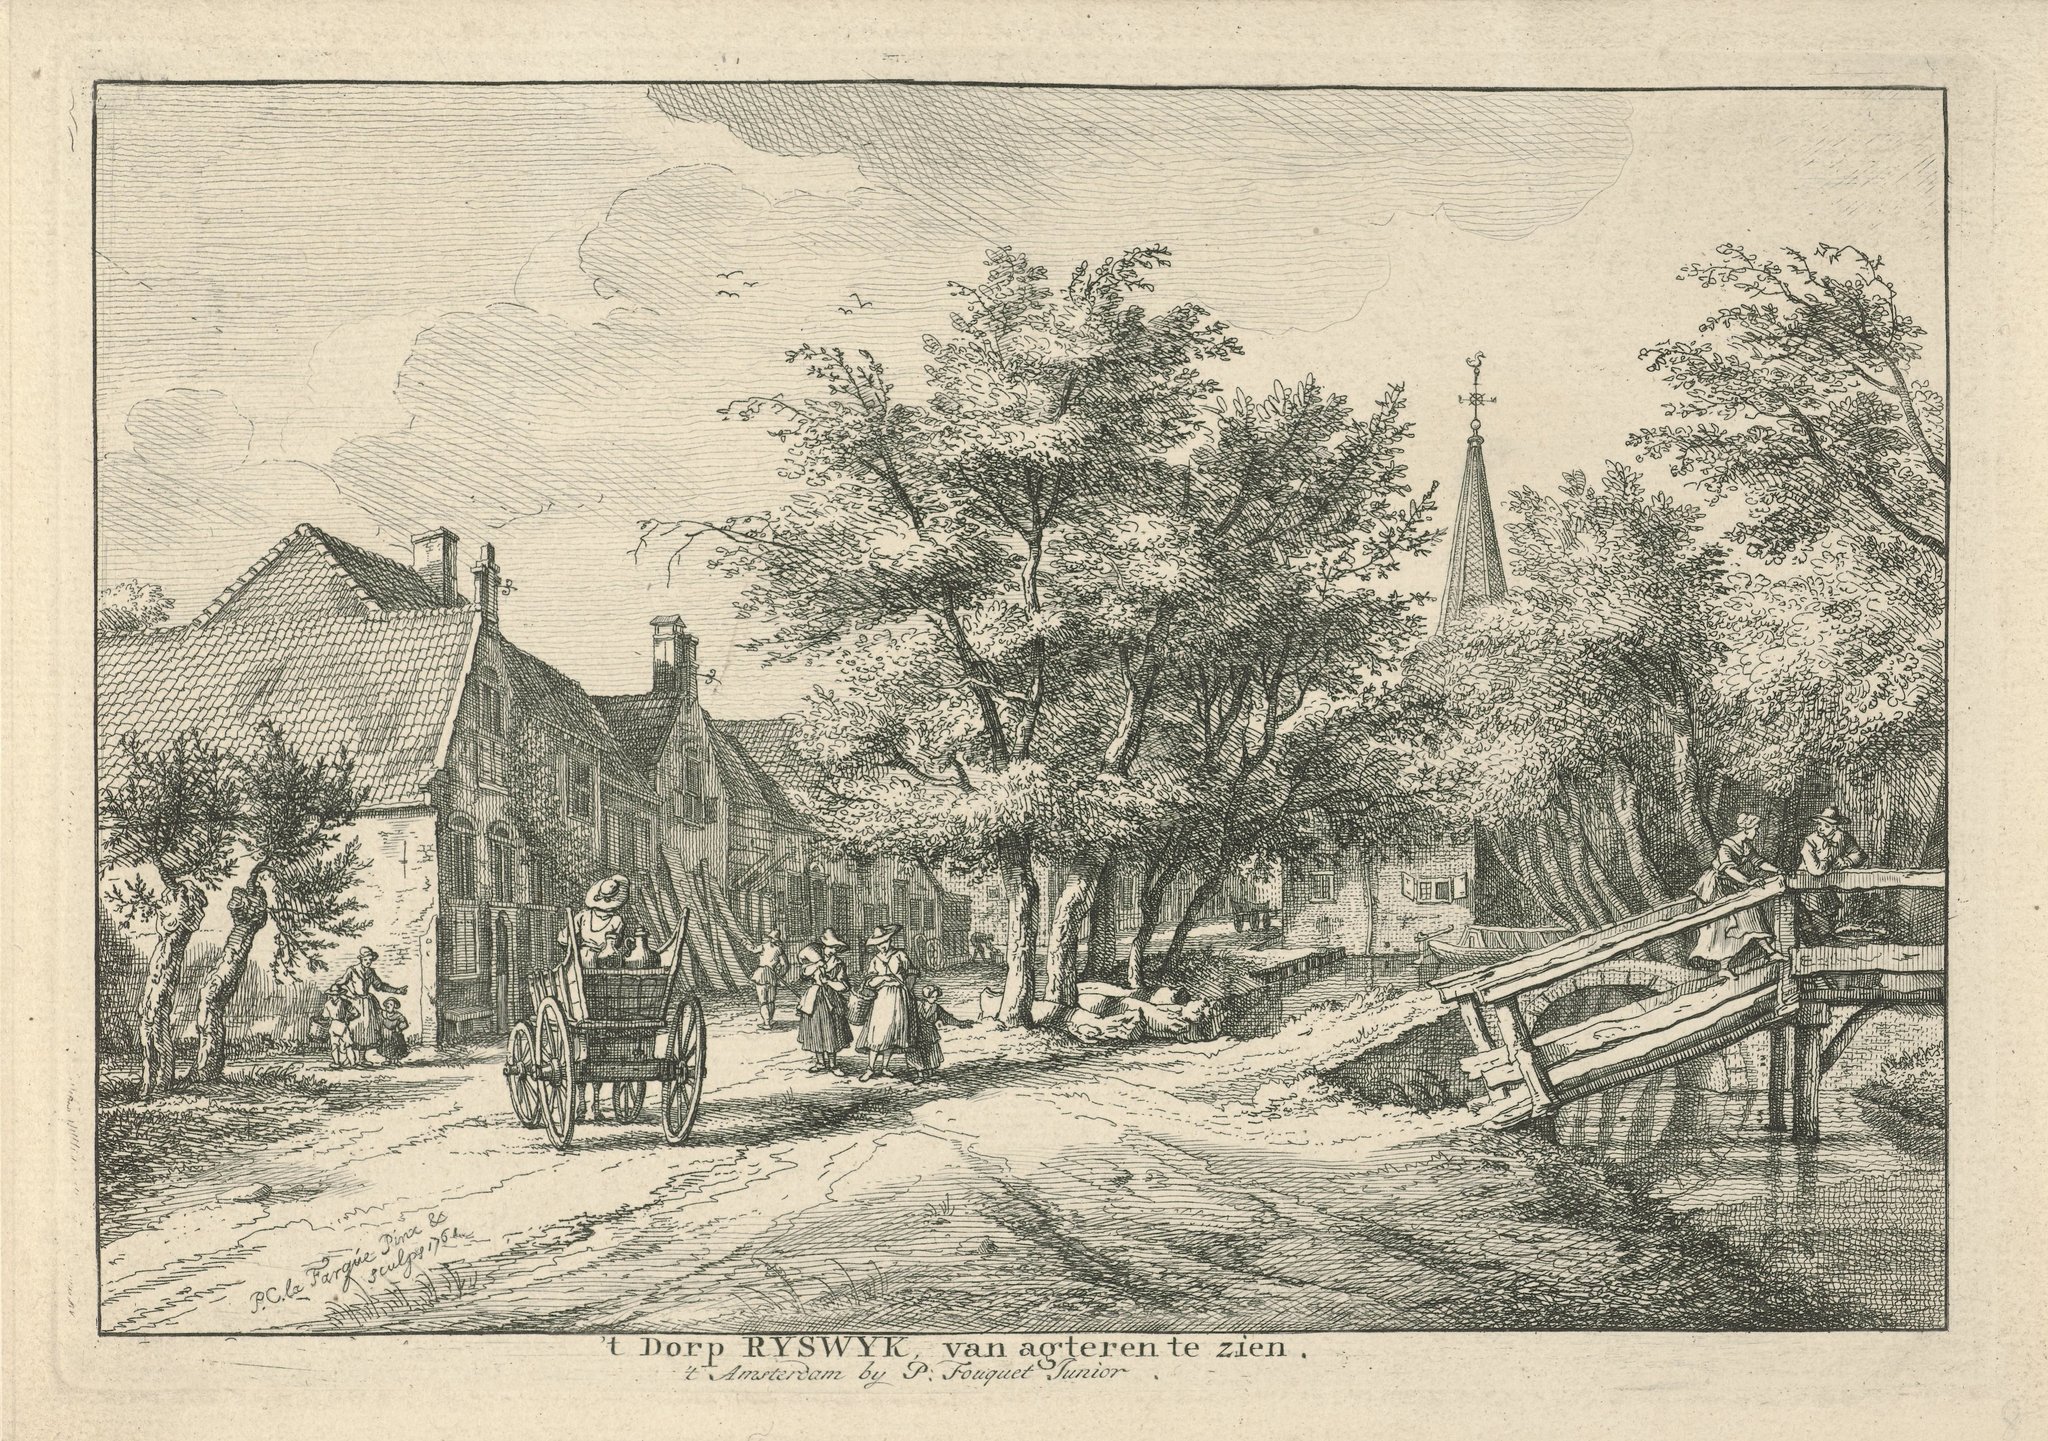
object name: print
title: Gezicht op Rijswijk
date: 1761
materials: paper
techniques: etching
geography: amsterdam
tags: canals, waters (in village), village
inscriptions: collector's mark: Lugt 2760, collector's mark: Lugt 2228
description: Gezicht op het dorp Rijswijk met een aan de vaart gelegen huizenrij. Rechts staan twee figuren op een brug over de vaart, links een figuur op een wagen en passanten.